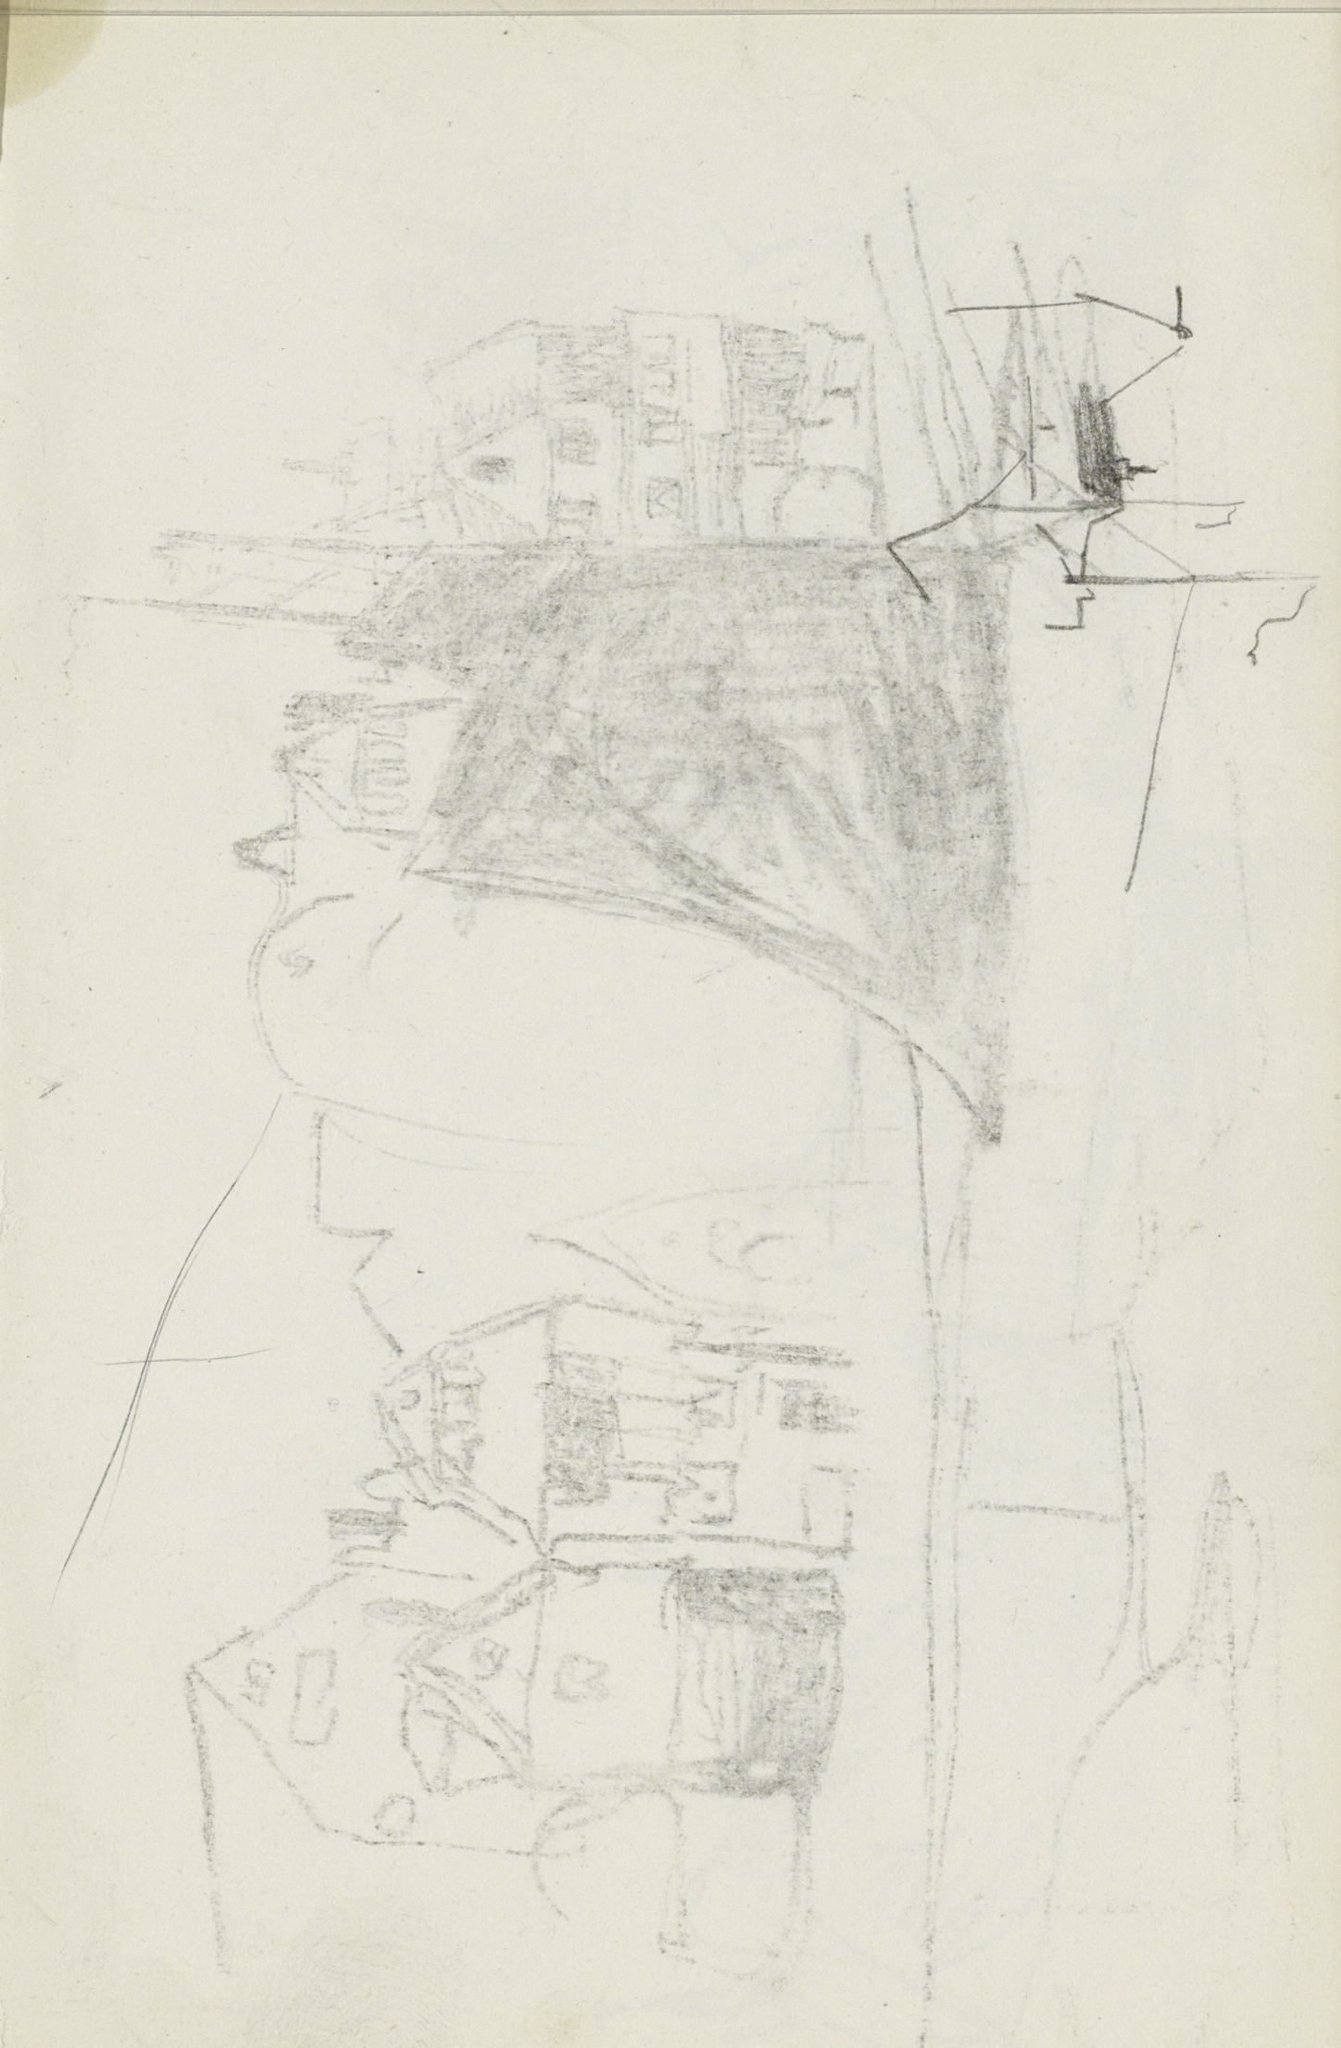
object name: sketchbook leaf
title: Gebouwen en vlaggenmasten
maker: isaac israels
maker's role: draughtsman, painter, print maker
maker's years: 1865-1934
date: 1875-1934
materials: chalk, paper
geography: london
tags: sailing-ship, sailing-boat, civic architecture; edifices; dwellings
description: Pagina 21 en pagina 22 uit schetsboek XXXV met 36 pagina's.